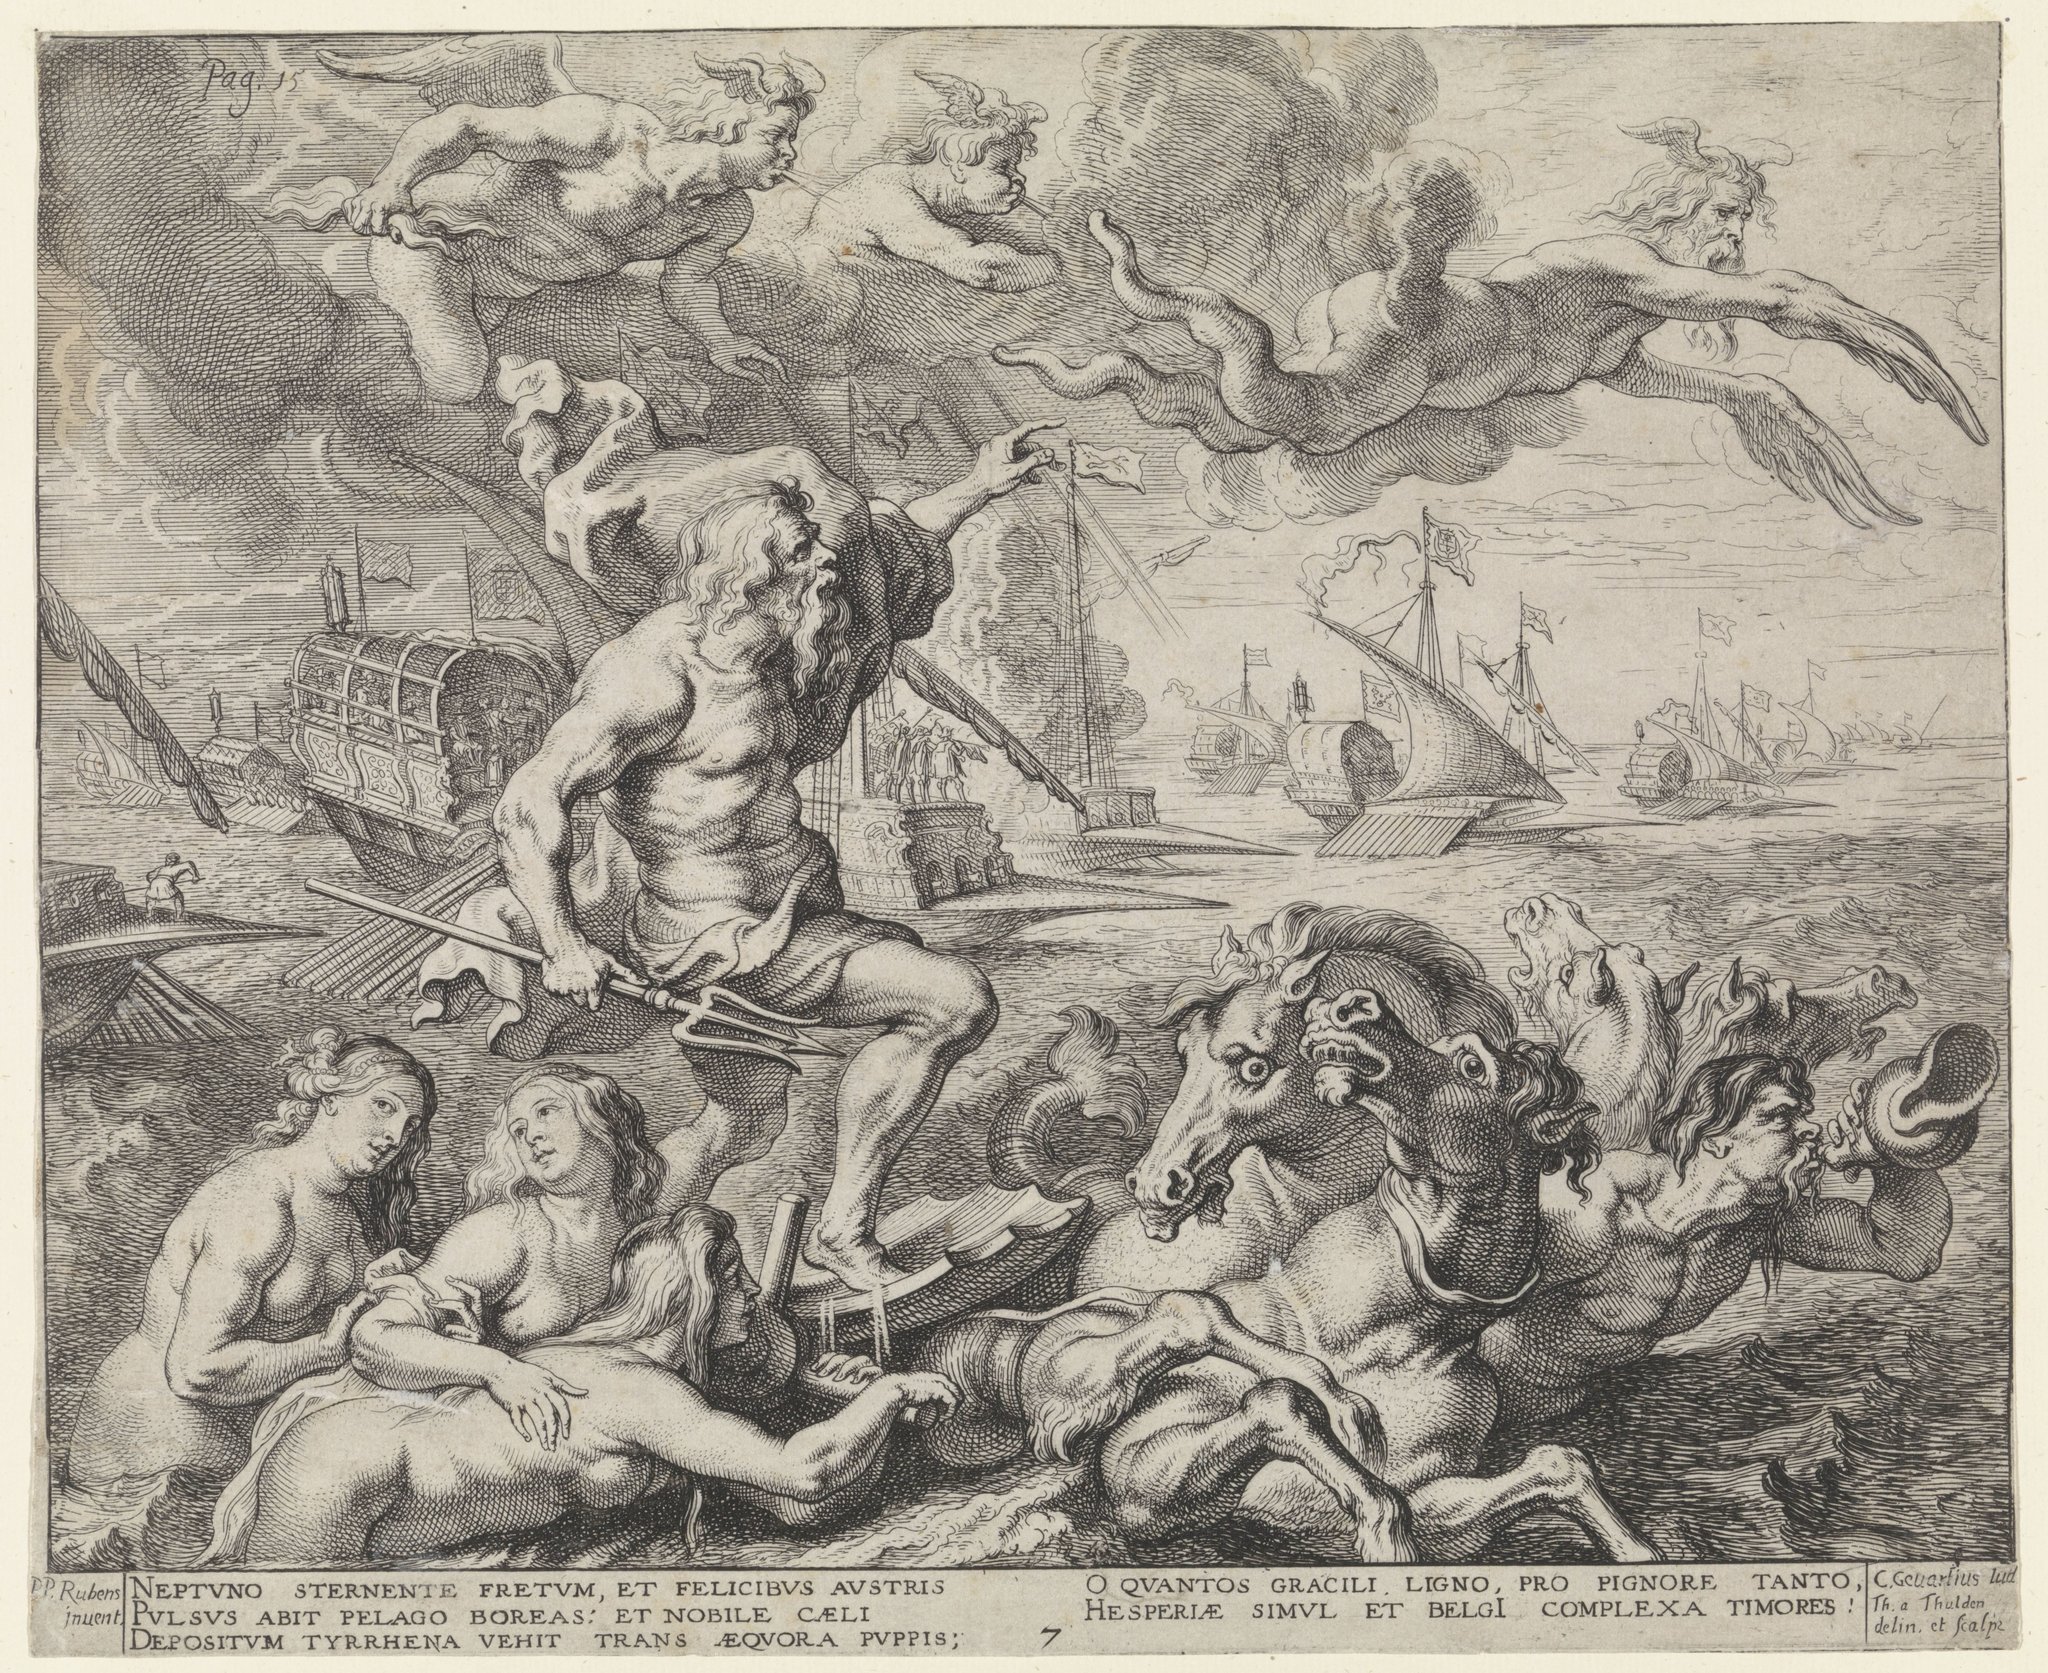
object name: print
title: De tocht van Barcelona naar Genua; intocht van Ferdinand te Antwerpen in 1635 (nr. 7)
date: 1642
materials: paper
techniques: engraving, etching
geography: antwerp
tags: north wind, 'aquilo', 'boreas', 'septentrionarius' (one of eight directions), triumphal entry and public reception, pageant, 'entrée solennelle', 'joyeuse entrée', specific aspects, allegorical aspects of neptune; neptune as patron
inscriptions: collector's mark: Lugt 2228, collector's mark: Lugt 2760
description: Ferdinands reis over zee van Barcelona naar Genua in Italië (11 april - 5 mei 1633). Op de voorgrond Neptunus in zijn strijdwagen met zeenimfen, terwijl hij de noorderwind Boreas verjaagt. De linker voorstelling op het welkomsttoneel. Gemerkt linksboven: Pag. 15. Met onderschrift van 5 regels in het Latijn. Blad nr. 7 in een geheel van 43 platen die de uitgave van de beschrijving van de intocht van de Kardinaal Infant Ferdinand van Oostenrijk te Antwerpen op 5 mei 1635 als de nieuwe landvoogd voor de Spaanse Nederlanden illustreren.